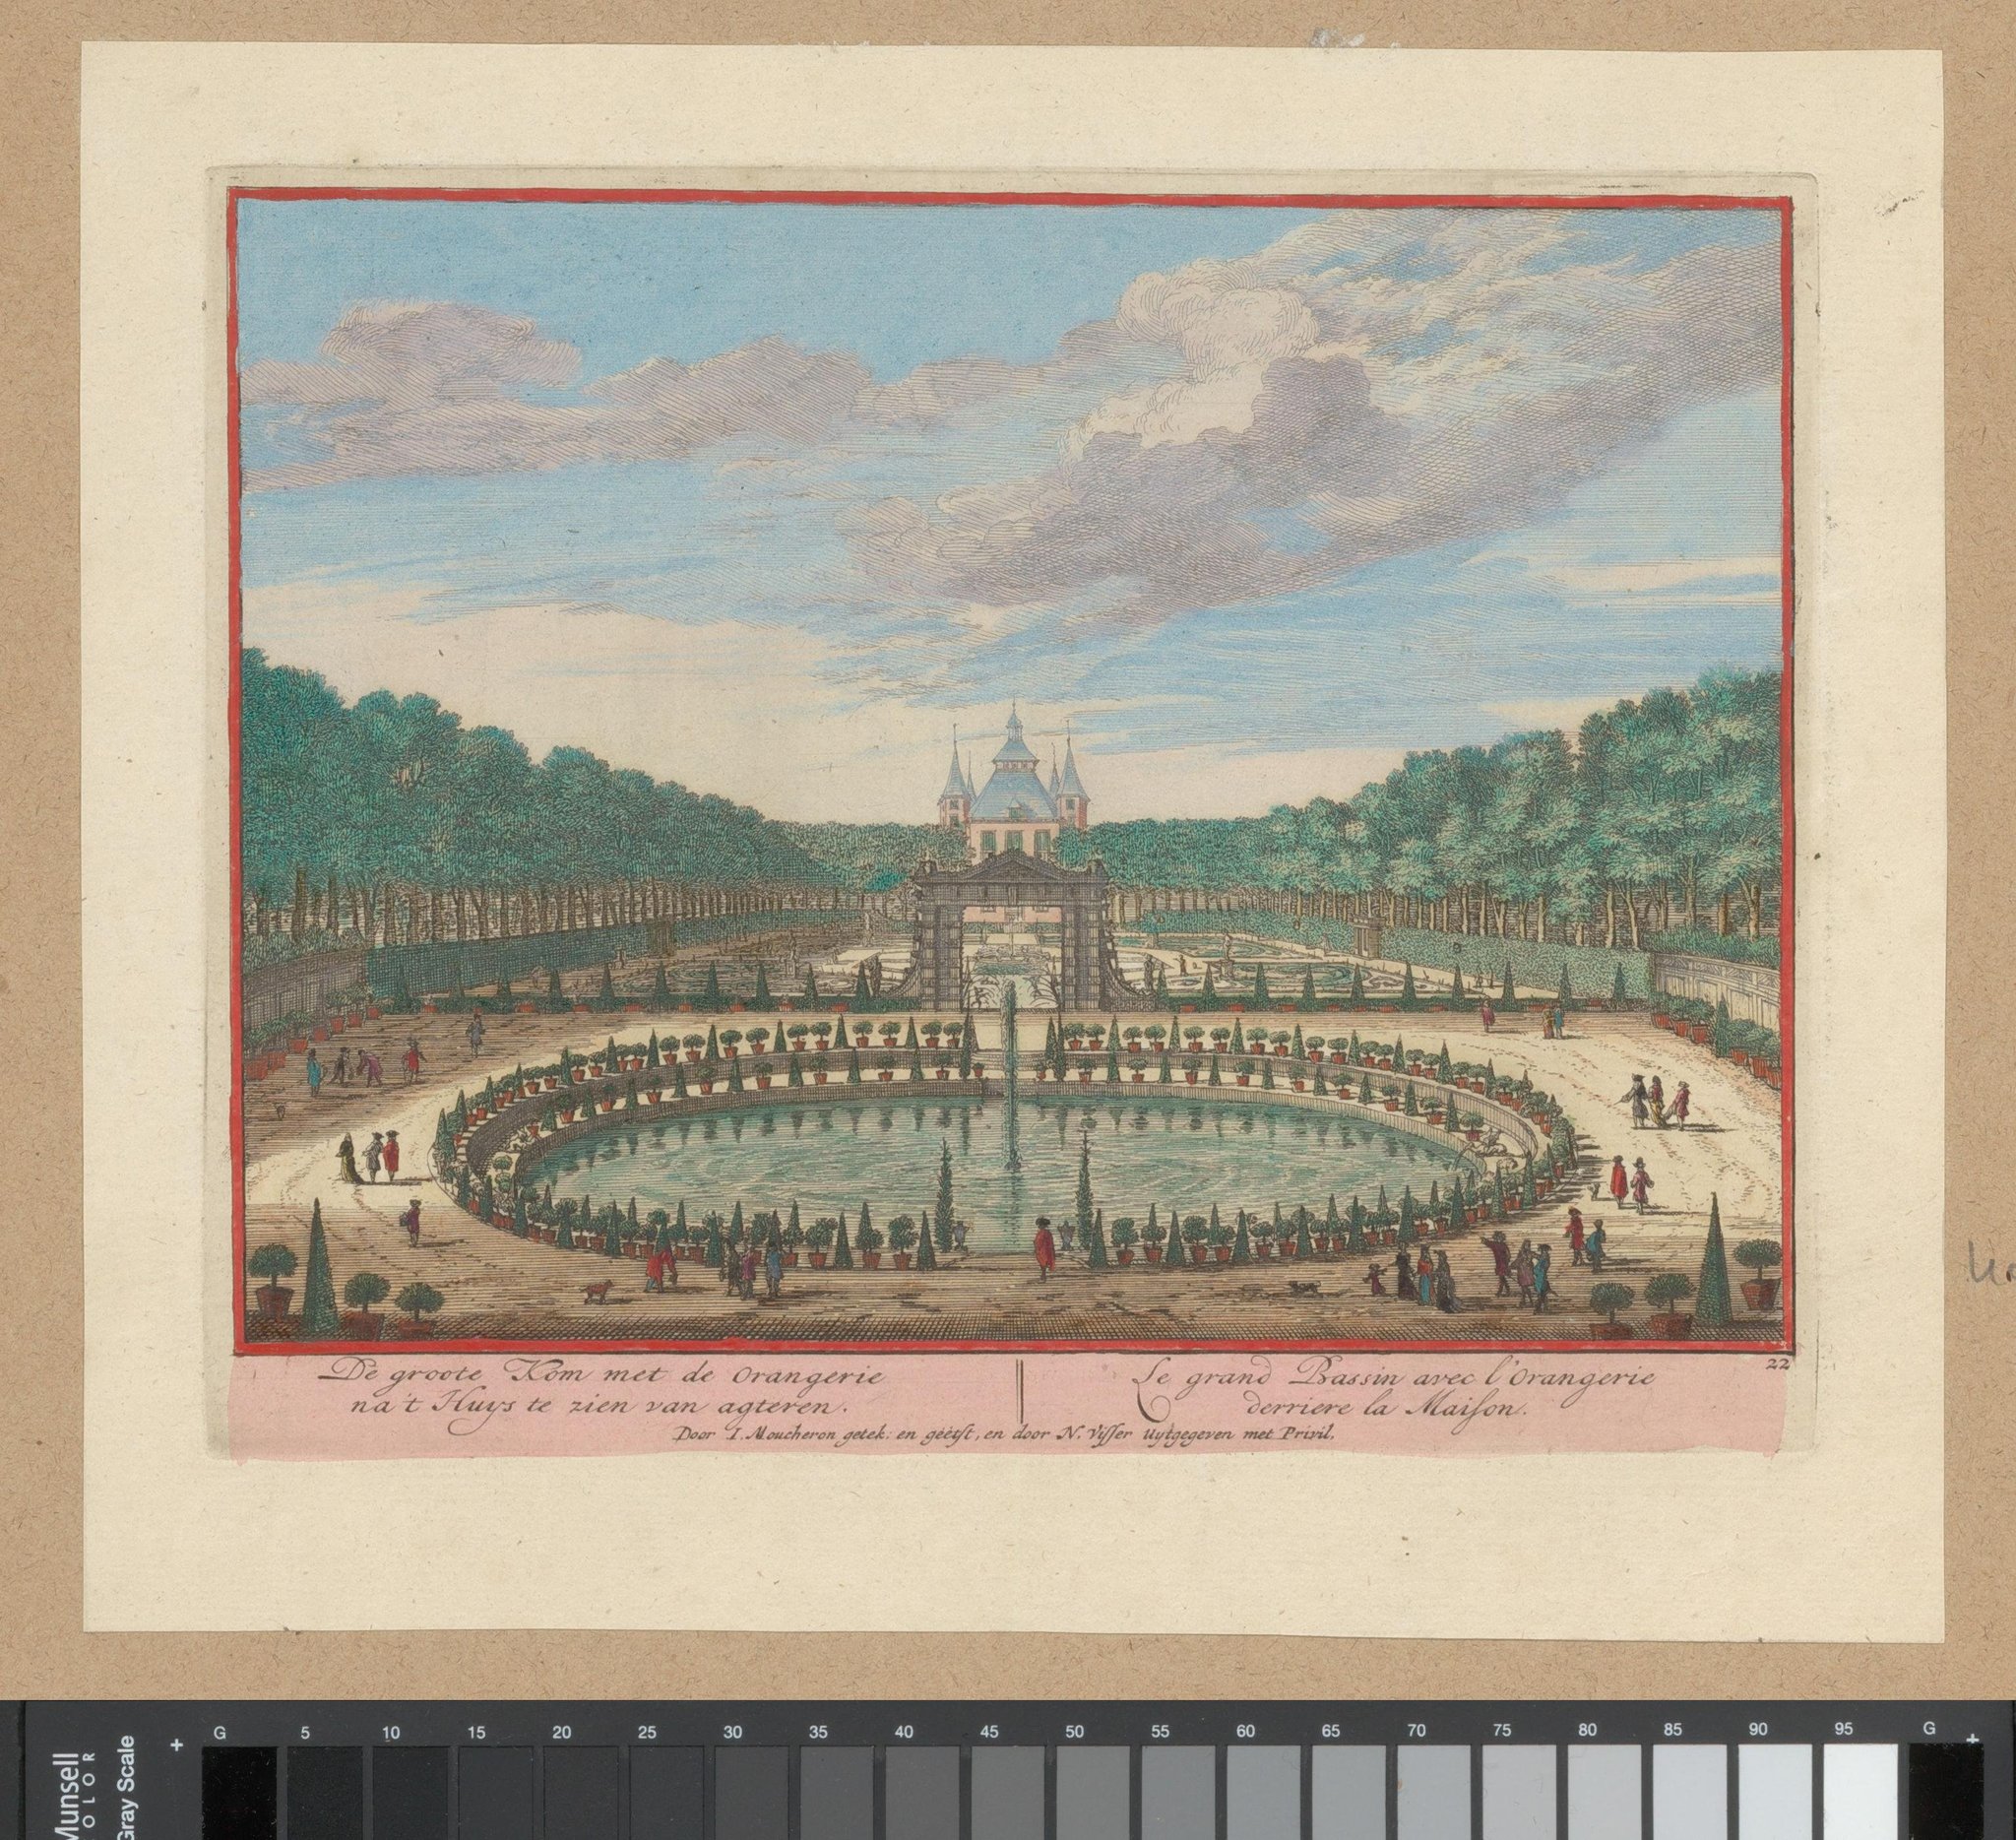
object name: print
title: Grote vijver bij Kasteel Heemstede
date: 1706-1719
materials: paper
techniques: engraving, etching, hand coloring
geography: amsterdam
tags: french or architectonic garden; formal garden, garden pond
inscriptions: collector's mark: Lugt 1641, stamp, stamp, stamp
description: Gezicht vanuit de orangerie op de ronde vijver en de parterres richting het huis. Rond om de vijver boompjes in potten. Onder de poort naar de parterres bedriegers. Rechtsonder genummerd: 22. Onderwerpsrubrieken binnen de Atlas Zeden en Gewoonten: Zeden en Gewoonten in Engeren Zin, De Woning, Oude Nederlandsche Tuinkunst, De 17de en 18de eeuw. Stadtuinen.